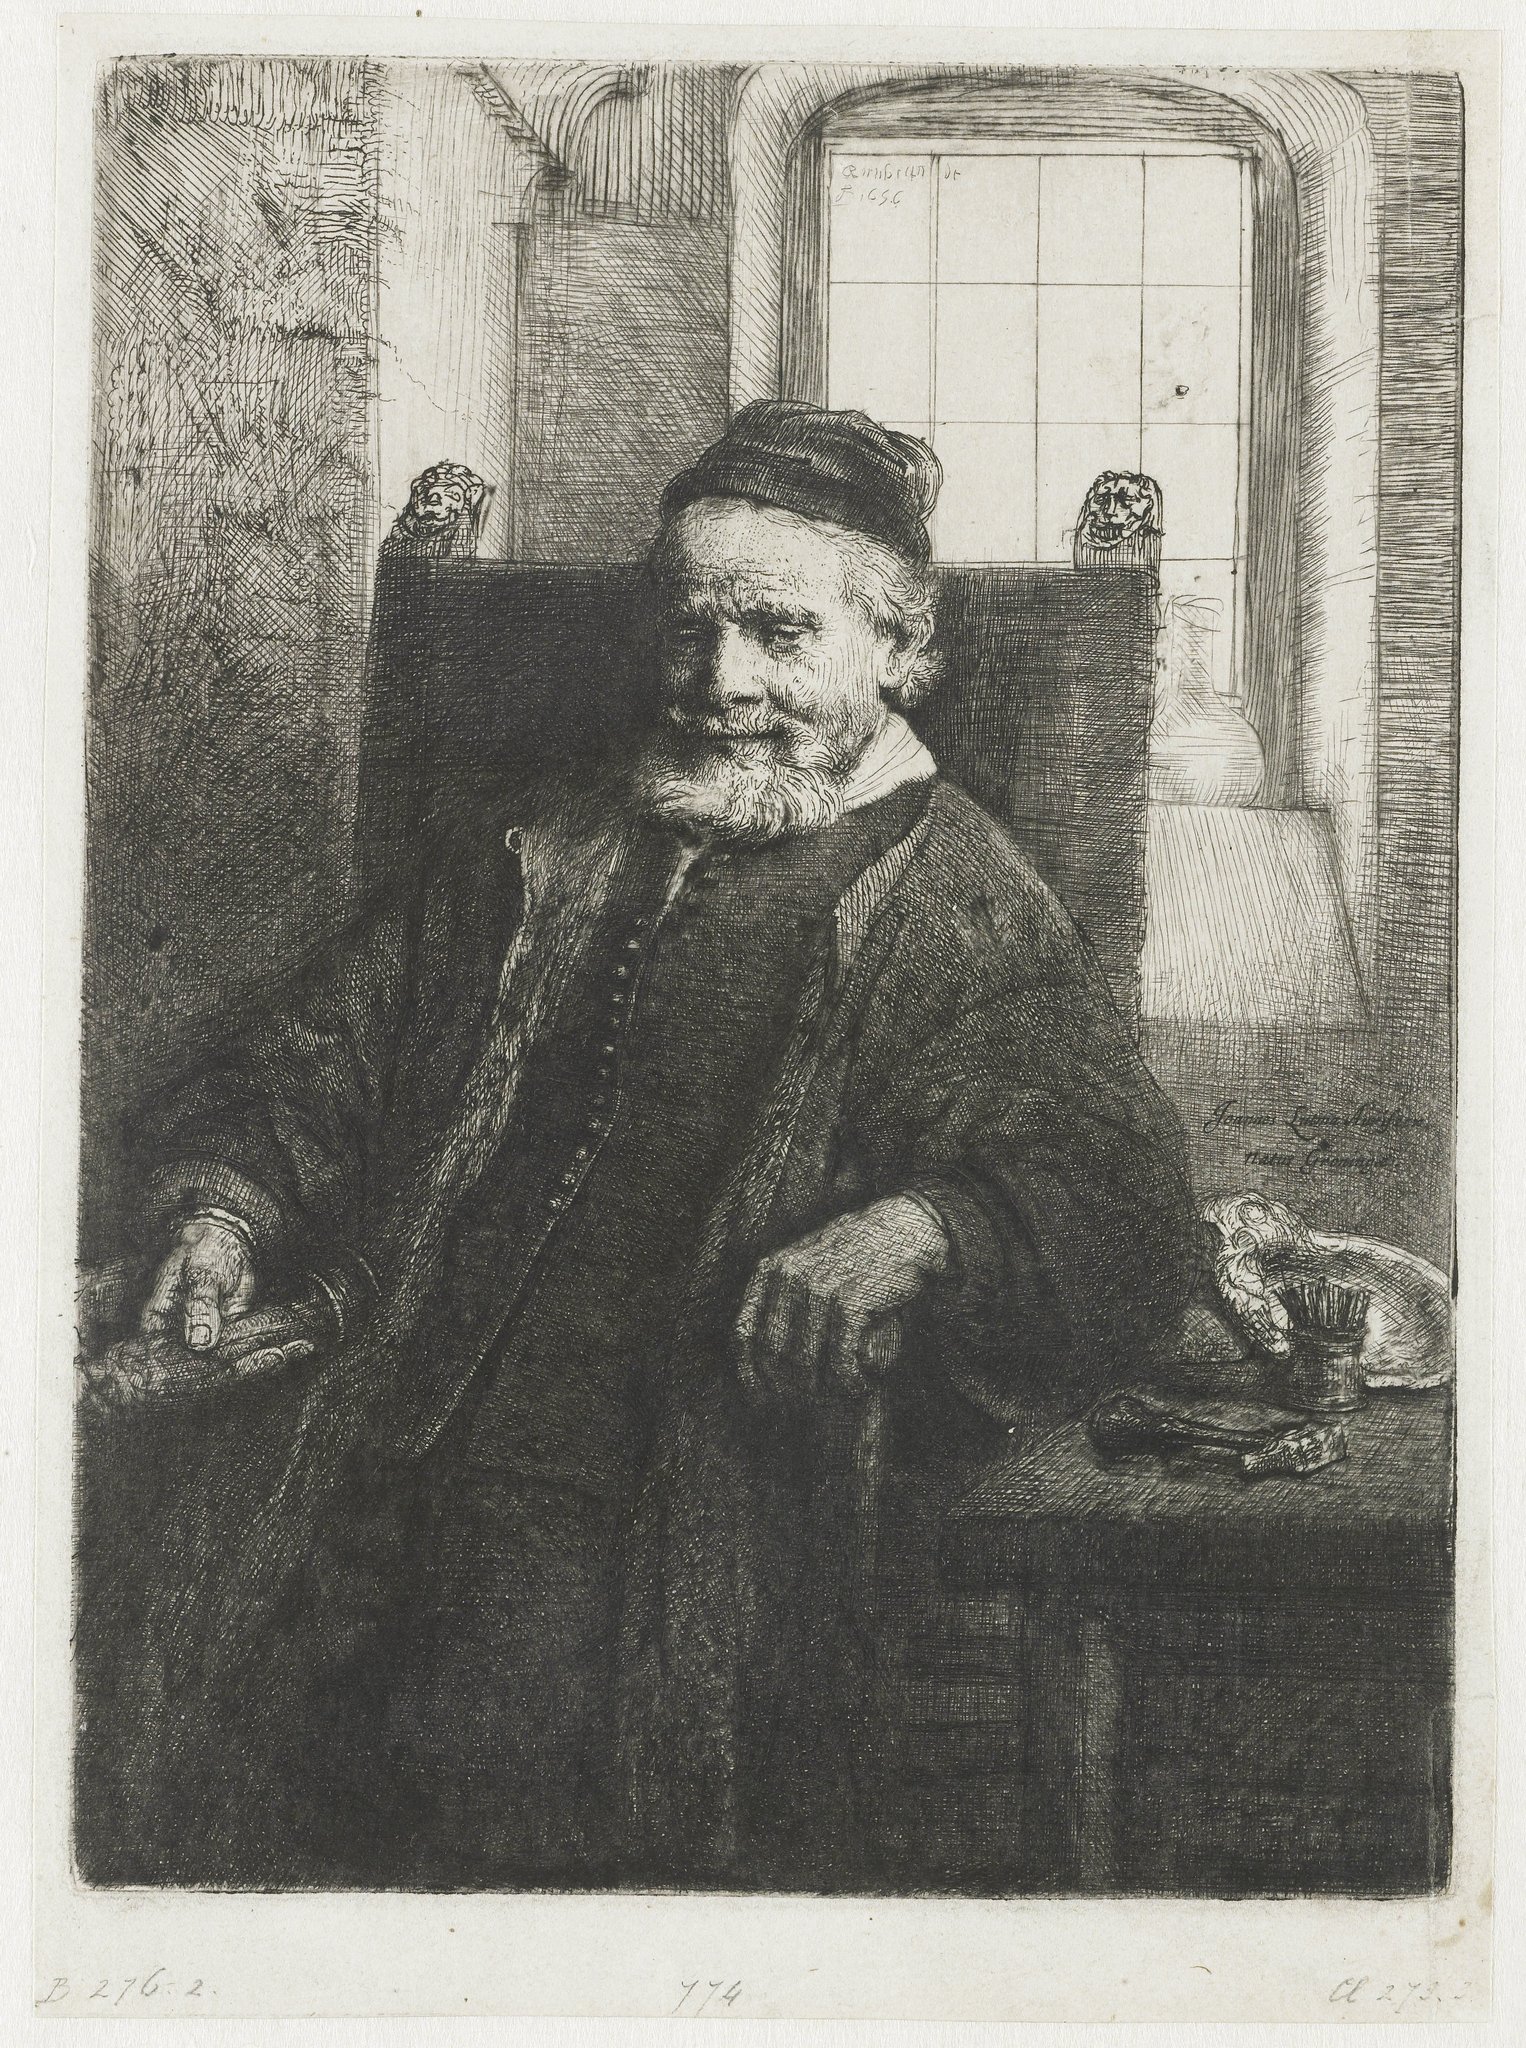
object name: print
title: Jan Lutma, goldsmith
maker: rembrandt van rijn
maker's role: draughtsman, painter, print maker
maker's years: 1606-1669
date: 1656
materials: paper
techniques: drypoint, etching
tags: amsterdam, print maker, draughtsman, silversmith, johannes lutma (1584-1669)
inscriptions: signature and date: ‘Rembrandt f 1656’, collector's mark: Lugt 240